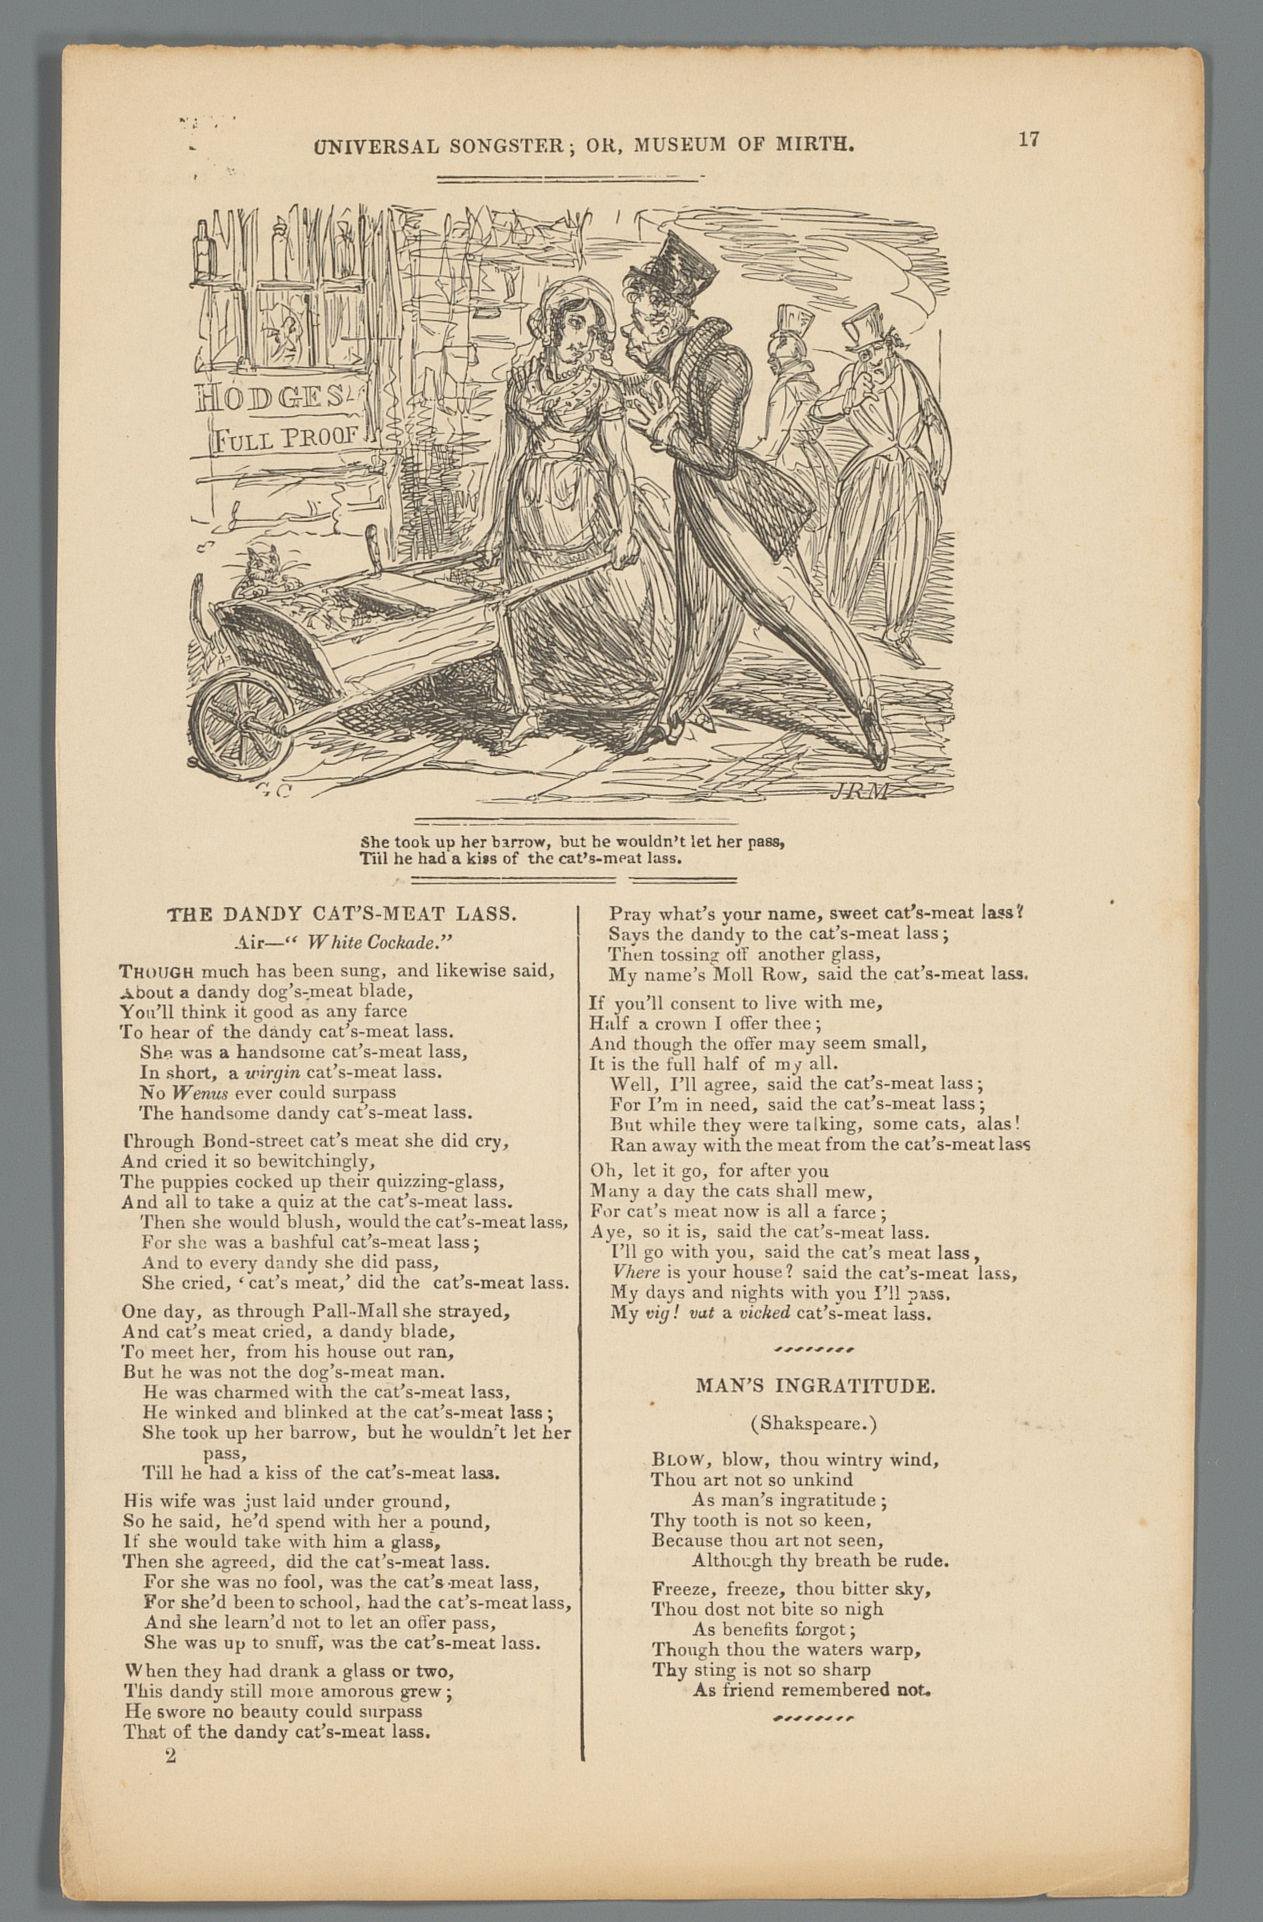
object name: cartoon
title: Spotprent bij het lied: The dandy cat's meat lass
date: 1825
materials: paper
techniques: engraving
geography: london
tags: wheelbarrow, lovers; courting, flirting, political caricatures and satires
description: Een man wil een kus van een jonge vrouw met een kruiwagen met kattenvoer. Spotprent bij een blad met de tekst van het lied: The dandy cat's meat lass. Illustratie (p. 17/18) genomen uit een uitgave van de liederenbundel: The Universal Songster, or Museum of Mirth, vol. I., eerst verschenen in 1825.